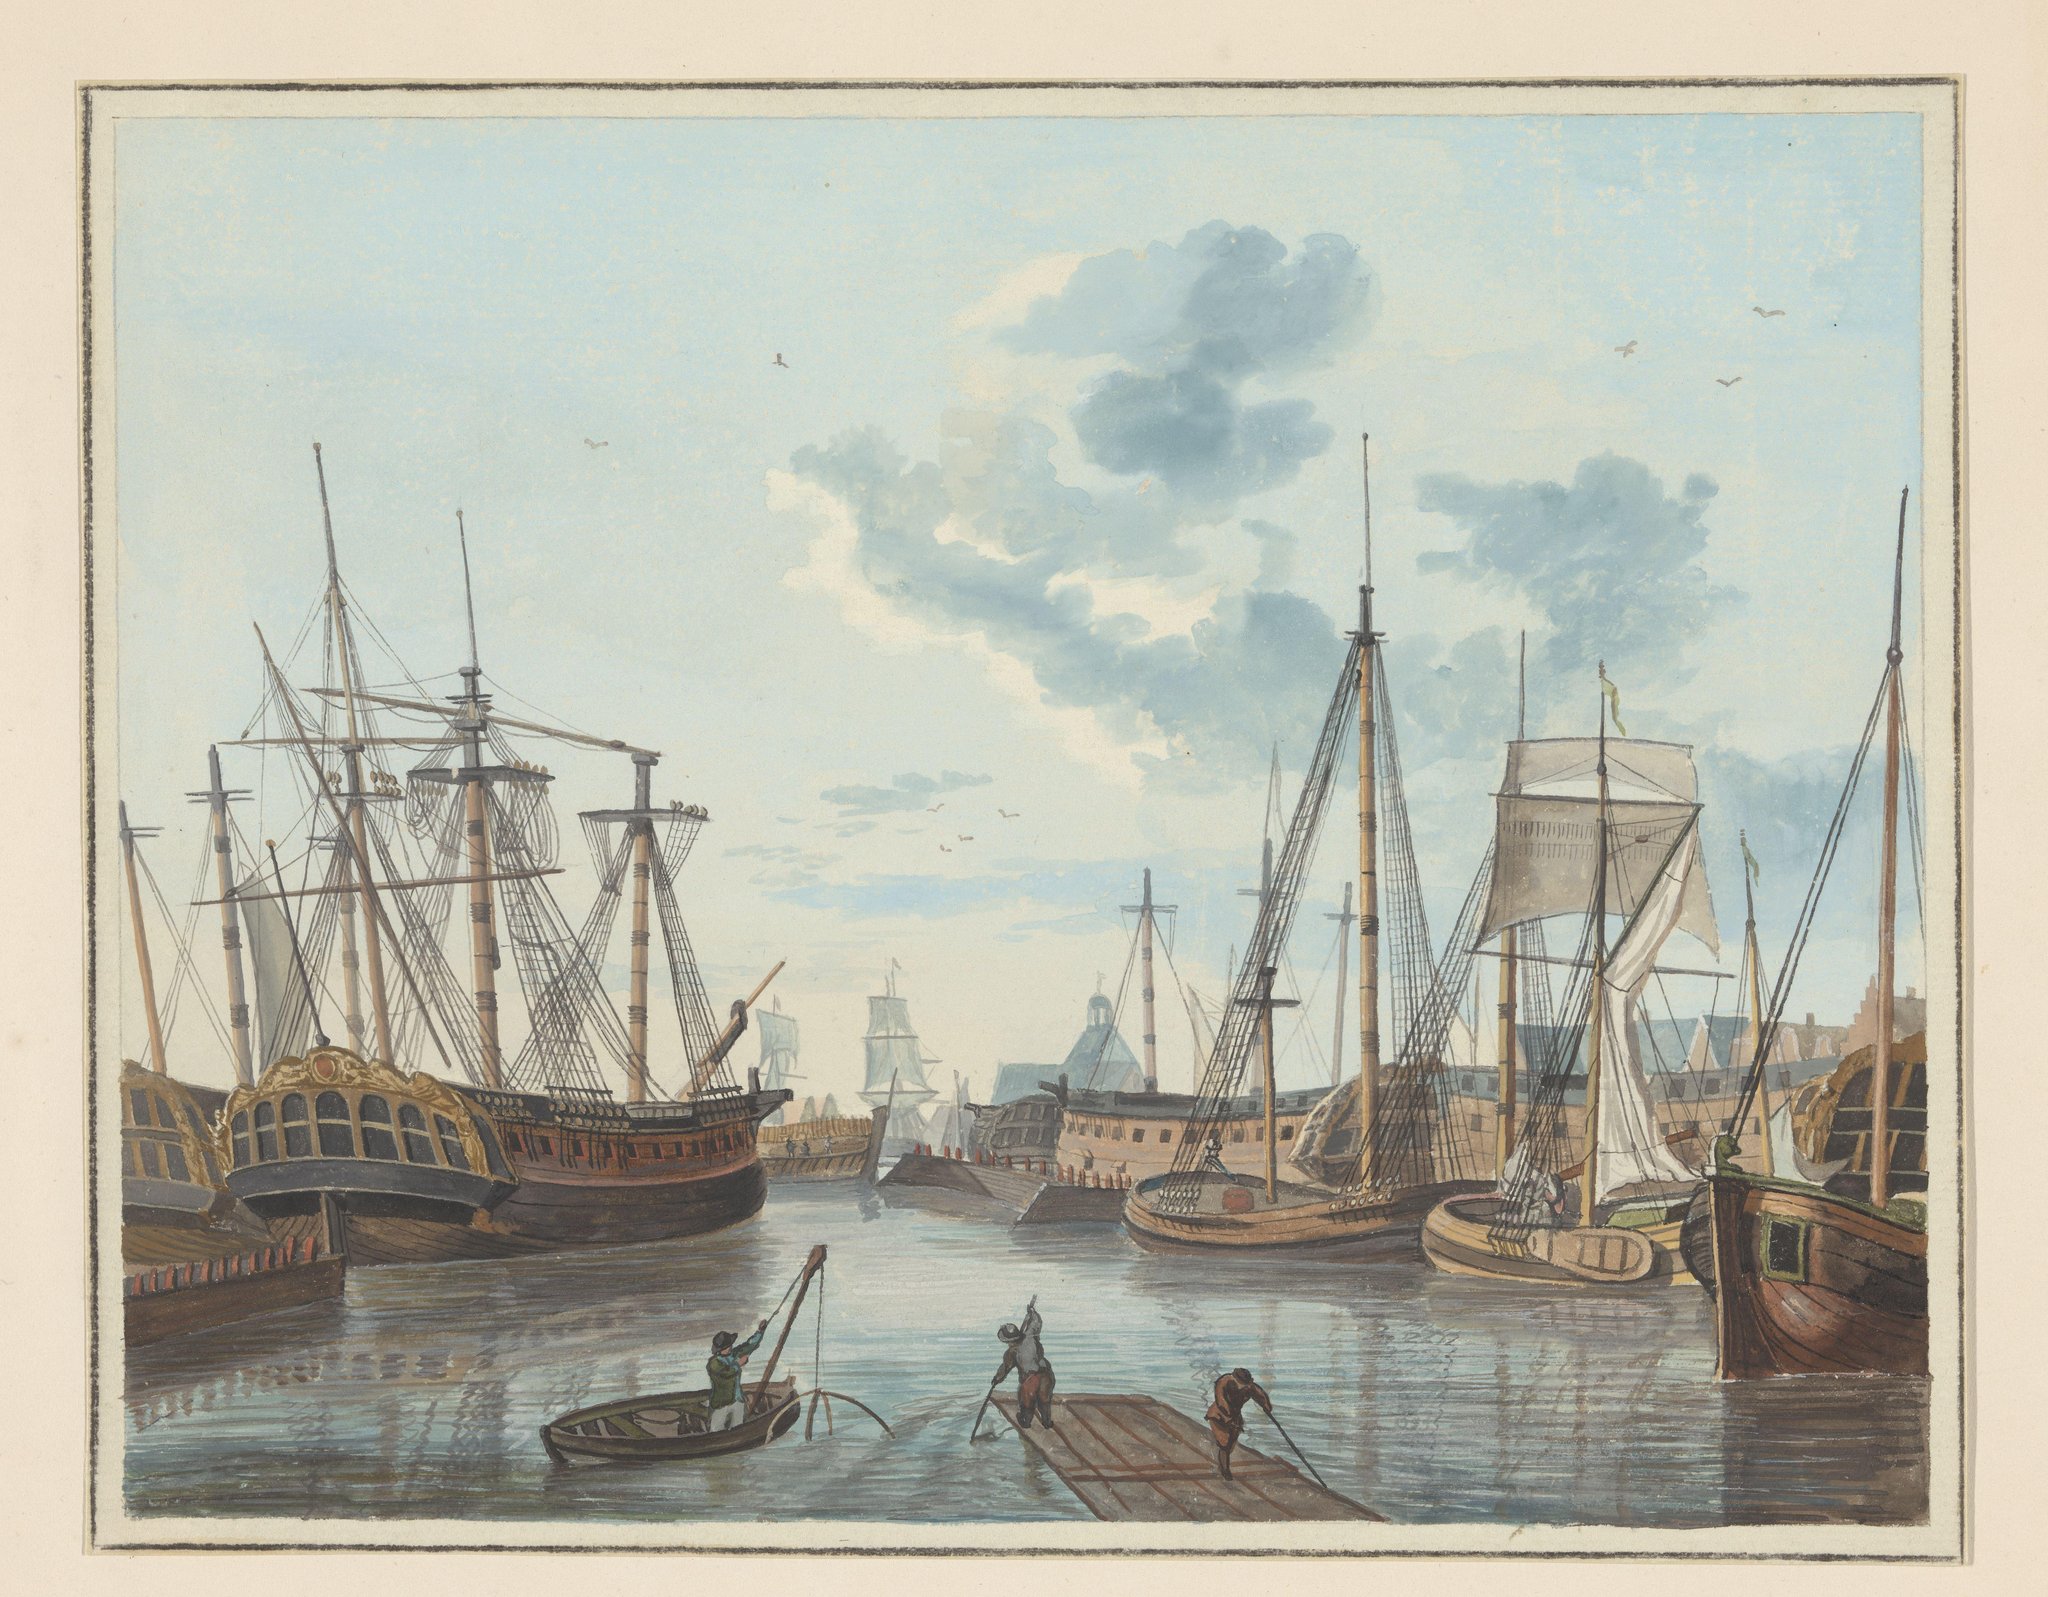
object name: watercolor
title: Gezicht op de scheepstimmerwerf van de Admiraliteit van Amsterdam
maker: Anonymous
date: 1850-1900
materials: ink, paper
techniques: brush, pen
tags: church (exterior), shipyard, shipdock - cc - more than one ship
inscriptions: inscription: ‘Het zogenaamd "Dok" waar 's Lands Oorlogschepen liggen bij de Admiraliteits Scheepstimmerwerf te Amsterdam met de Oosterkerk in 't verschiet’, collector's mark: Lugt 2233